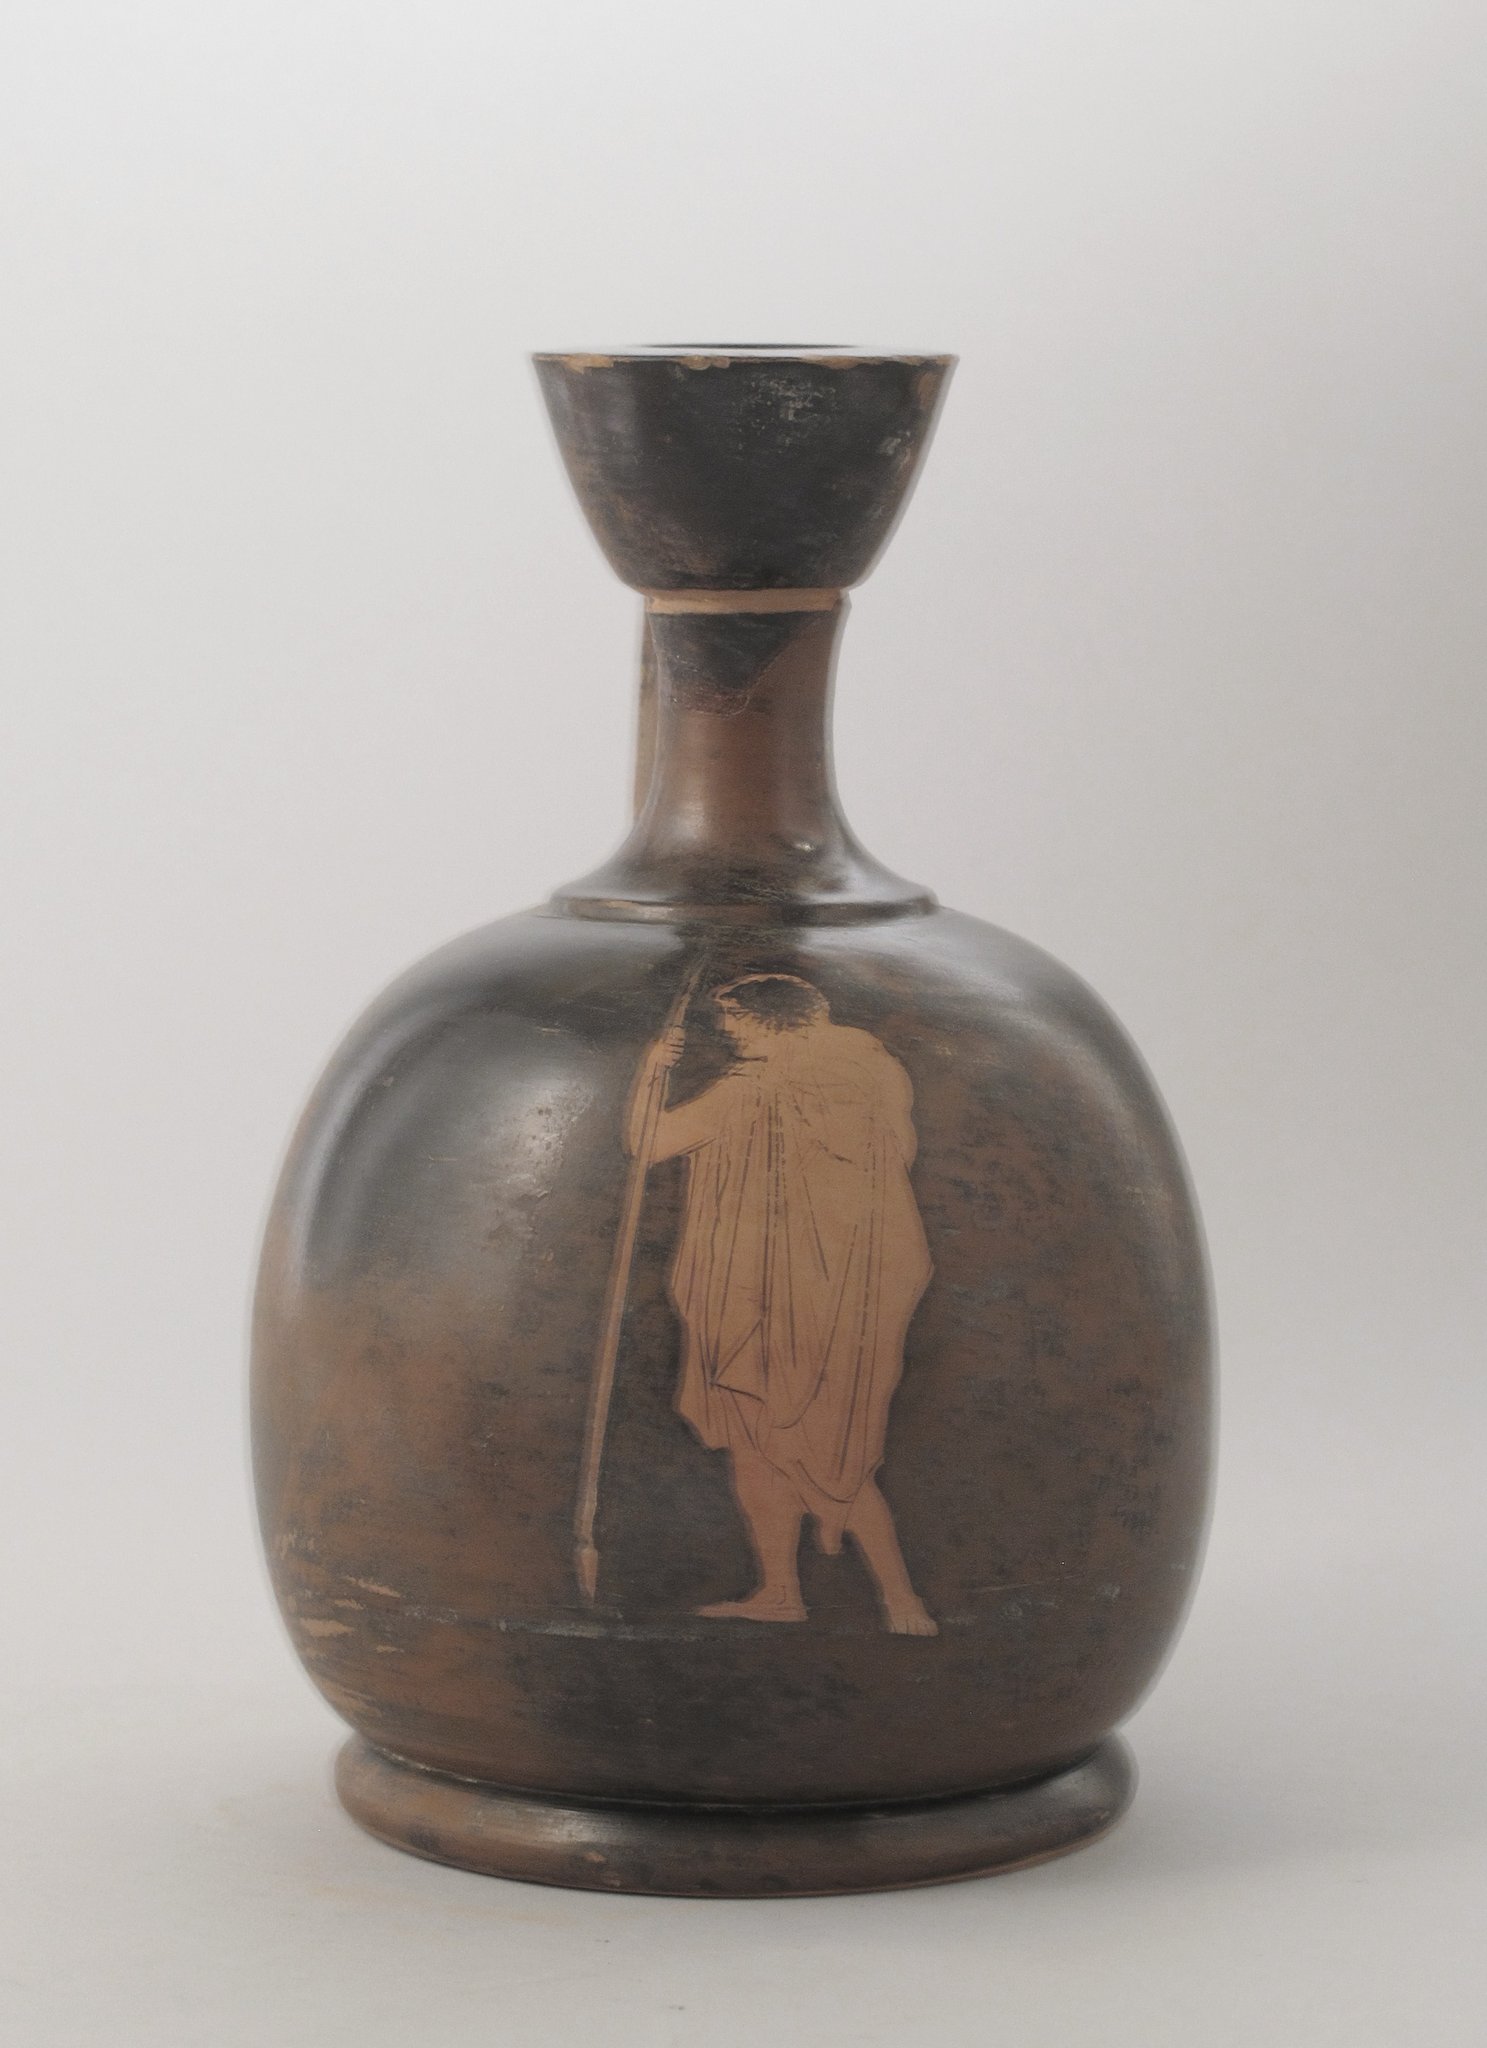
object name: squat lekythos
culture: greek, attic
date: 450 BCE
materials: terracotta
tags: men